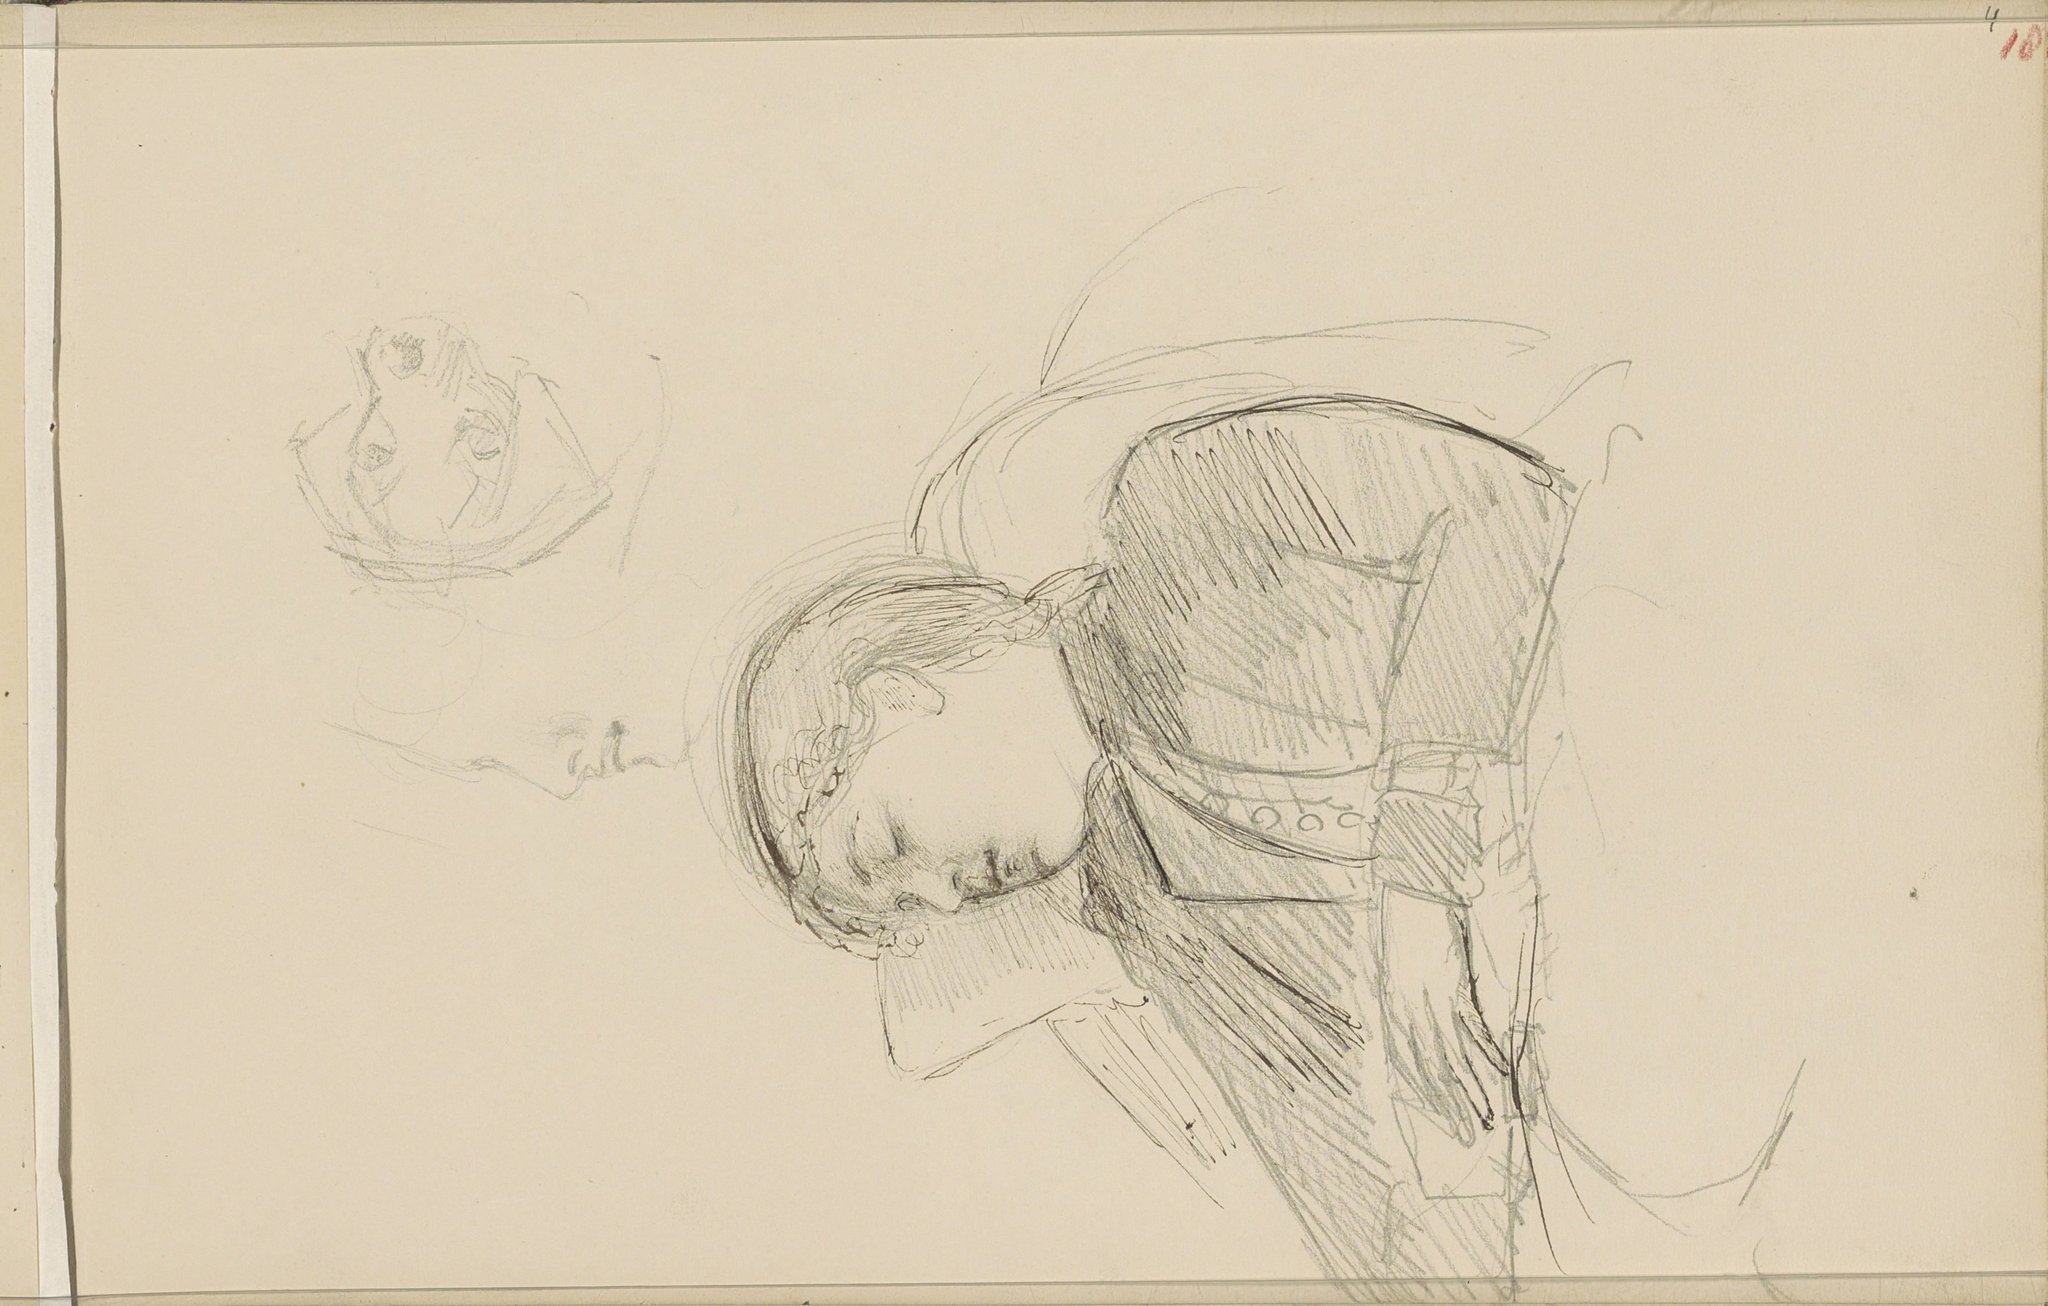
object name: sketchbook leaf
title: Slapende vrouw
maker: jozef israëls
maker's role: draughtsman, painter, print maker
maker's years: 1824-1911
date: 1834-1911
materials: ink, paper, pencil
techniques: pen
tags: sleeping; unconsciousness, dog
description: De vrouw leunt achterover met haar hoofd tegen een kussen. Tevens een studie van het profiel van een gezicht en een hondenkop. Blad 4 recto uit een schetsboek met 25 bladen.